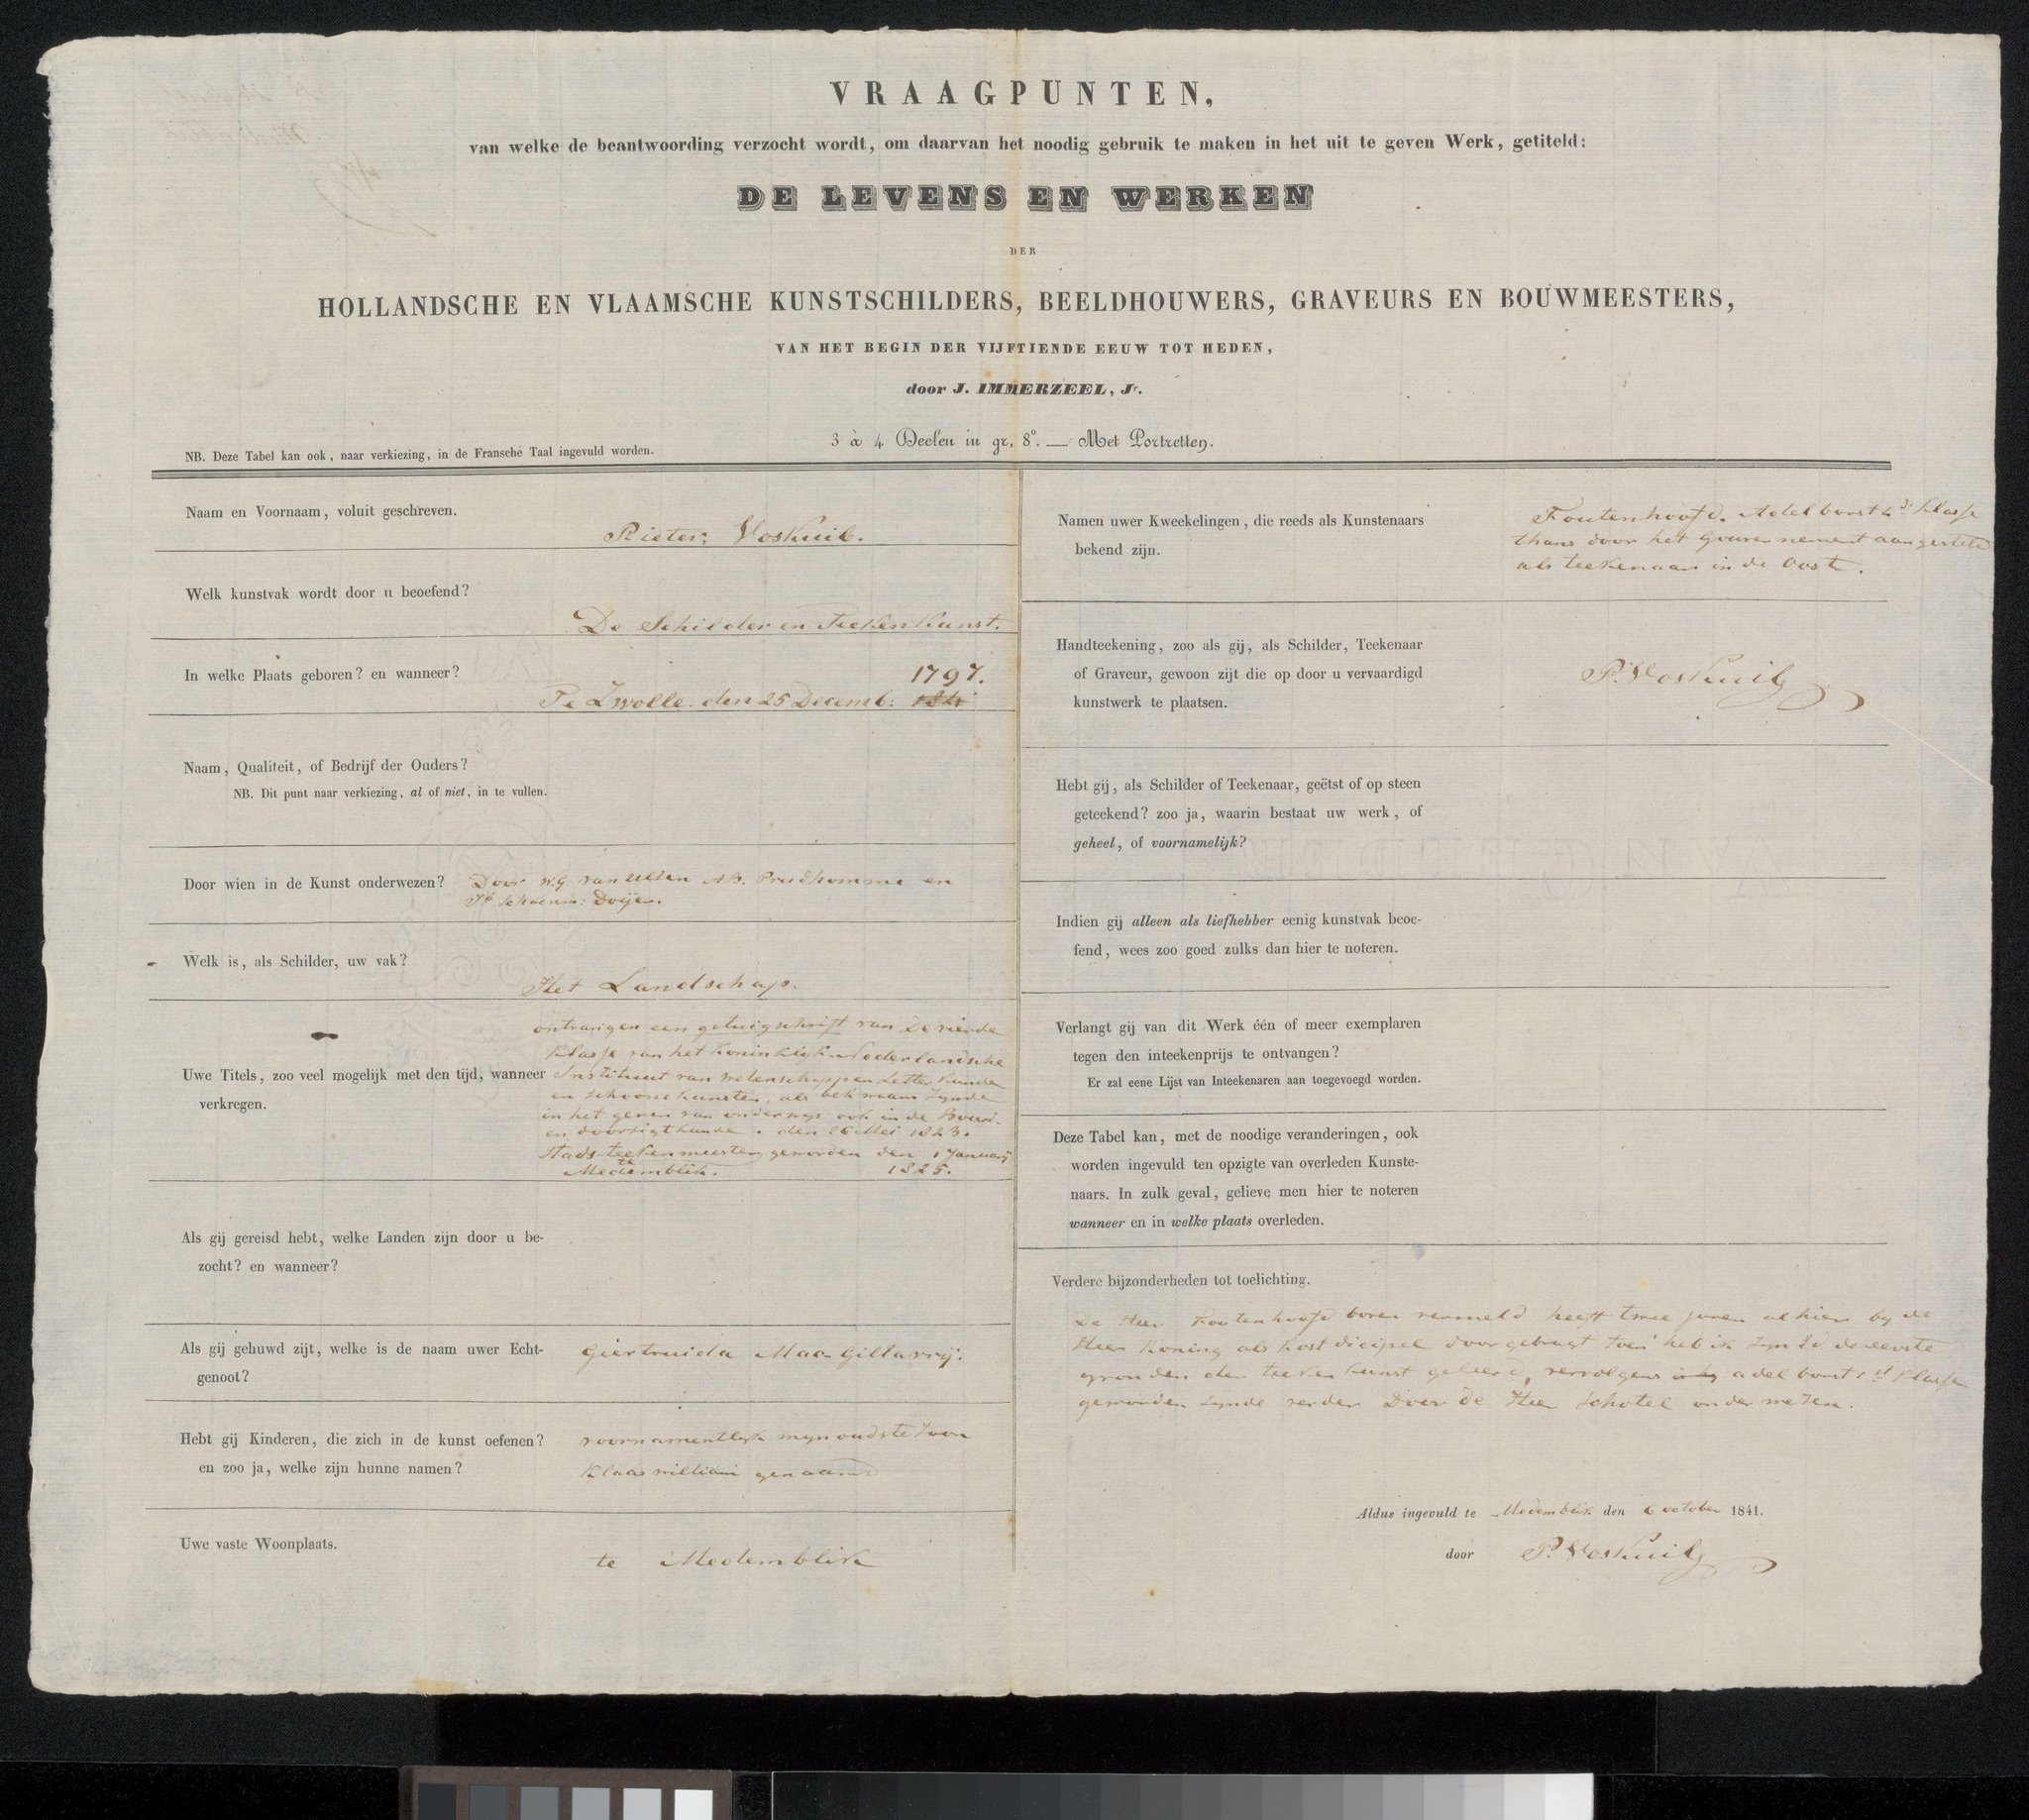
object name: manuscript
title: Enquêteformulier ingevuld door Pieter Voskuil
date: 1841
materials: ink, paper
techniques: pen, printing, writing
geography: medemblik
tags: painter, draughtsman, pieter voskuil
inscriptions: inscription: ‘Vraagpunten,/ van welke de beantwoording verzocht wordt, om daarvan het noodig gebruik te maken in het uit te geven Werk, getiteld: De levens en werken/ der Hollandsche en Vlaamsche kunstschilders, beeldhouwers,/ graveurs en bouwmeesters, van het begin der vijftiende eeuw tot heden/ door J. Immerzeel, Jr.’, watermark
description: Opgenomen in: Immerzeel, J. Jr., De levens en werken der Hollandsche en Vlaamsche kunstschilders, beeldhouwers, graveurs en bouwmeesters, van het begin der vijftiende eeuw tot heden, Amsterdam: J.C. van Kesteren, 1842-1843.